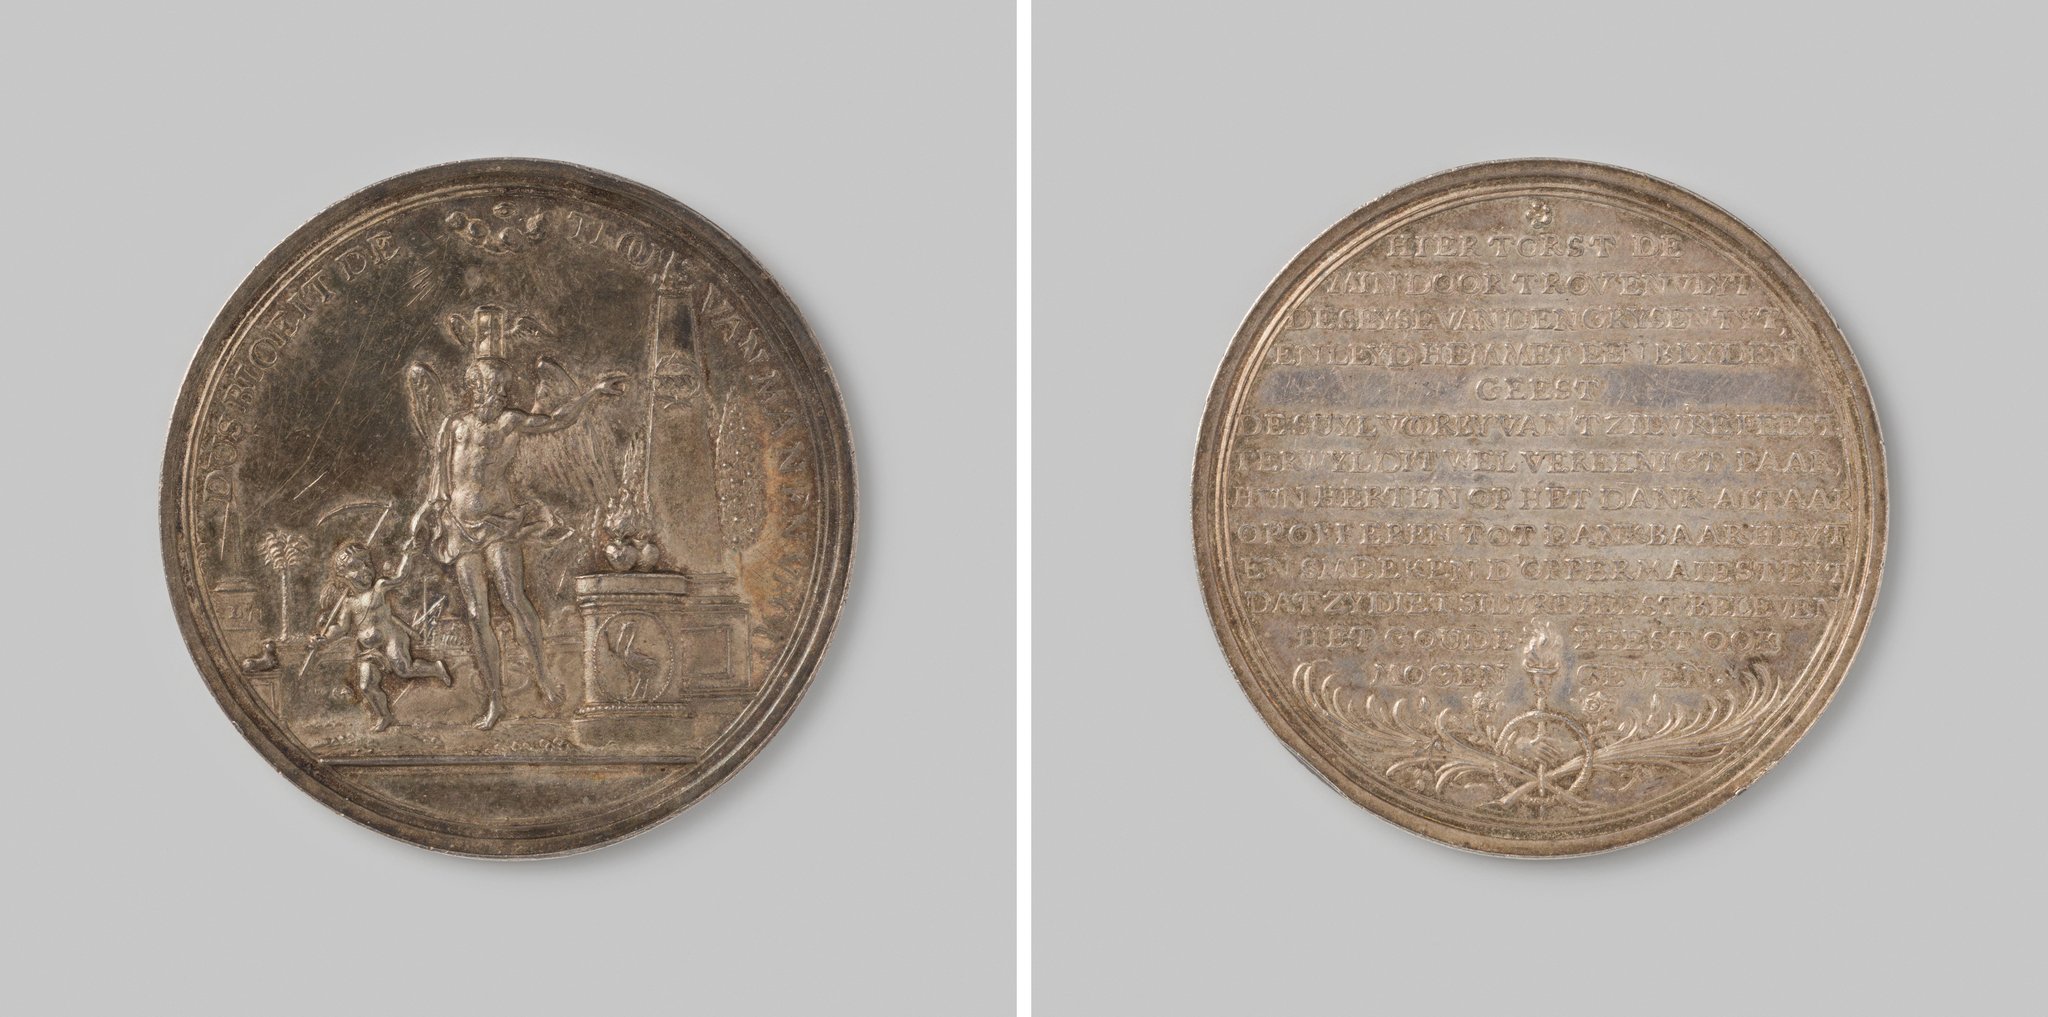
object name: history medal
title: 25-jarig huwelijk Pieter Volmer en Antje Grevingh 1767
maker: johan george holtzhey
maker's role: mintmaster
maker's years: 1726-1808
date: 1767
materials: silver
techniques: engraving, pressing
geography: amsterdam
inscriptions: inscription: ‘HIER TORST DE MIN/ DOOR TROV EN VLYT/ DE SEYSE VAN DEN GRYSEN TYT,/ EN LEYD HEM MET EEN BLYDEN/ GEEST/ DE SUYL VOORBY VAN 'T ZILV'RE FEEST/ TERWYL DIT WEL VEREENIGT PAAR,/ HUN HERTEN OP HET DANK-ALTAAR/ OPOFFEREN TOT DANKBAARHEYT/ EN SMEEKEN D' OPPERMAIESTEYT/ DAT ZY DIE 'T SILVRE FEEST BELEVEN/ HET GOUDE FEEST OOK/ MOGEN GEVEN.’, edge inscription: ‘PIETER VOLMER EN ANTJE GREVINGH GETROUWT 19 APRIL 1742. 'T ZILVRE FEEST GEV. 1767. (ster)’, circumscription: ‘DUS BLOEIT DE TROU - VAN MAN EN VROU’, signature: ‘L’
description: Zilveren penning, op de voorzijde een altaar versierd met ooievaar waarop twee brandende harten, waarachter een gevleugeld knaapje met zeis die de Tijd geleidt door een tuin, van een monument waarop XXV naar een waarop L, onder het stralende oog Gods, met omschrift, op de keerzijde dertien regels tekst boven een ornament van gekruisde palmtakken, een toorts en samengedrukte handen binnen een slangerond, in de rand een gelegenheidsgravure.